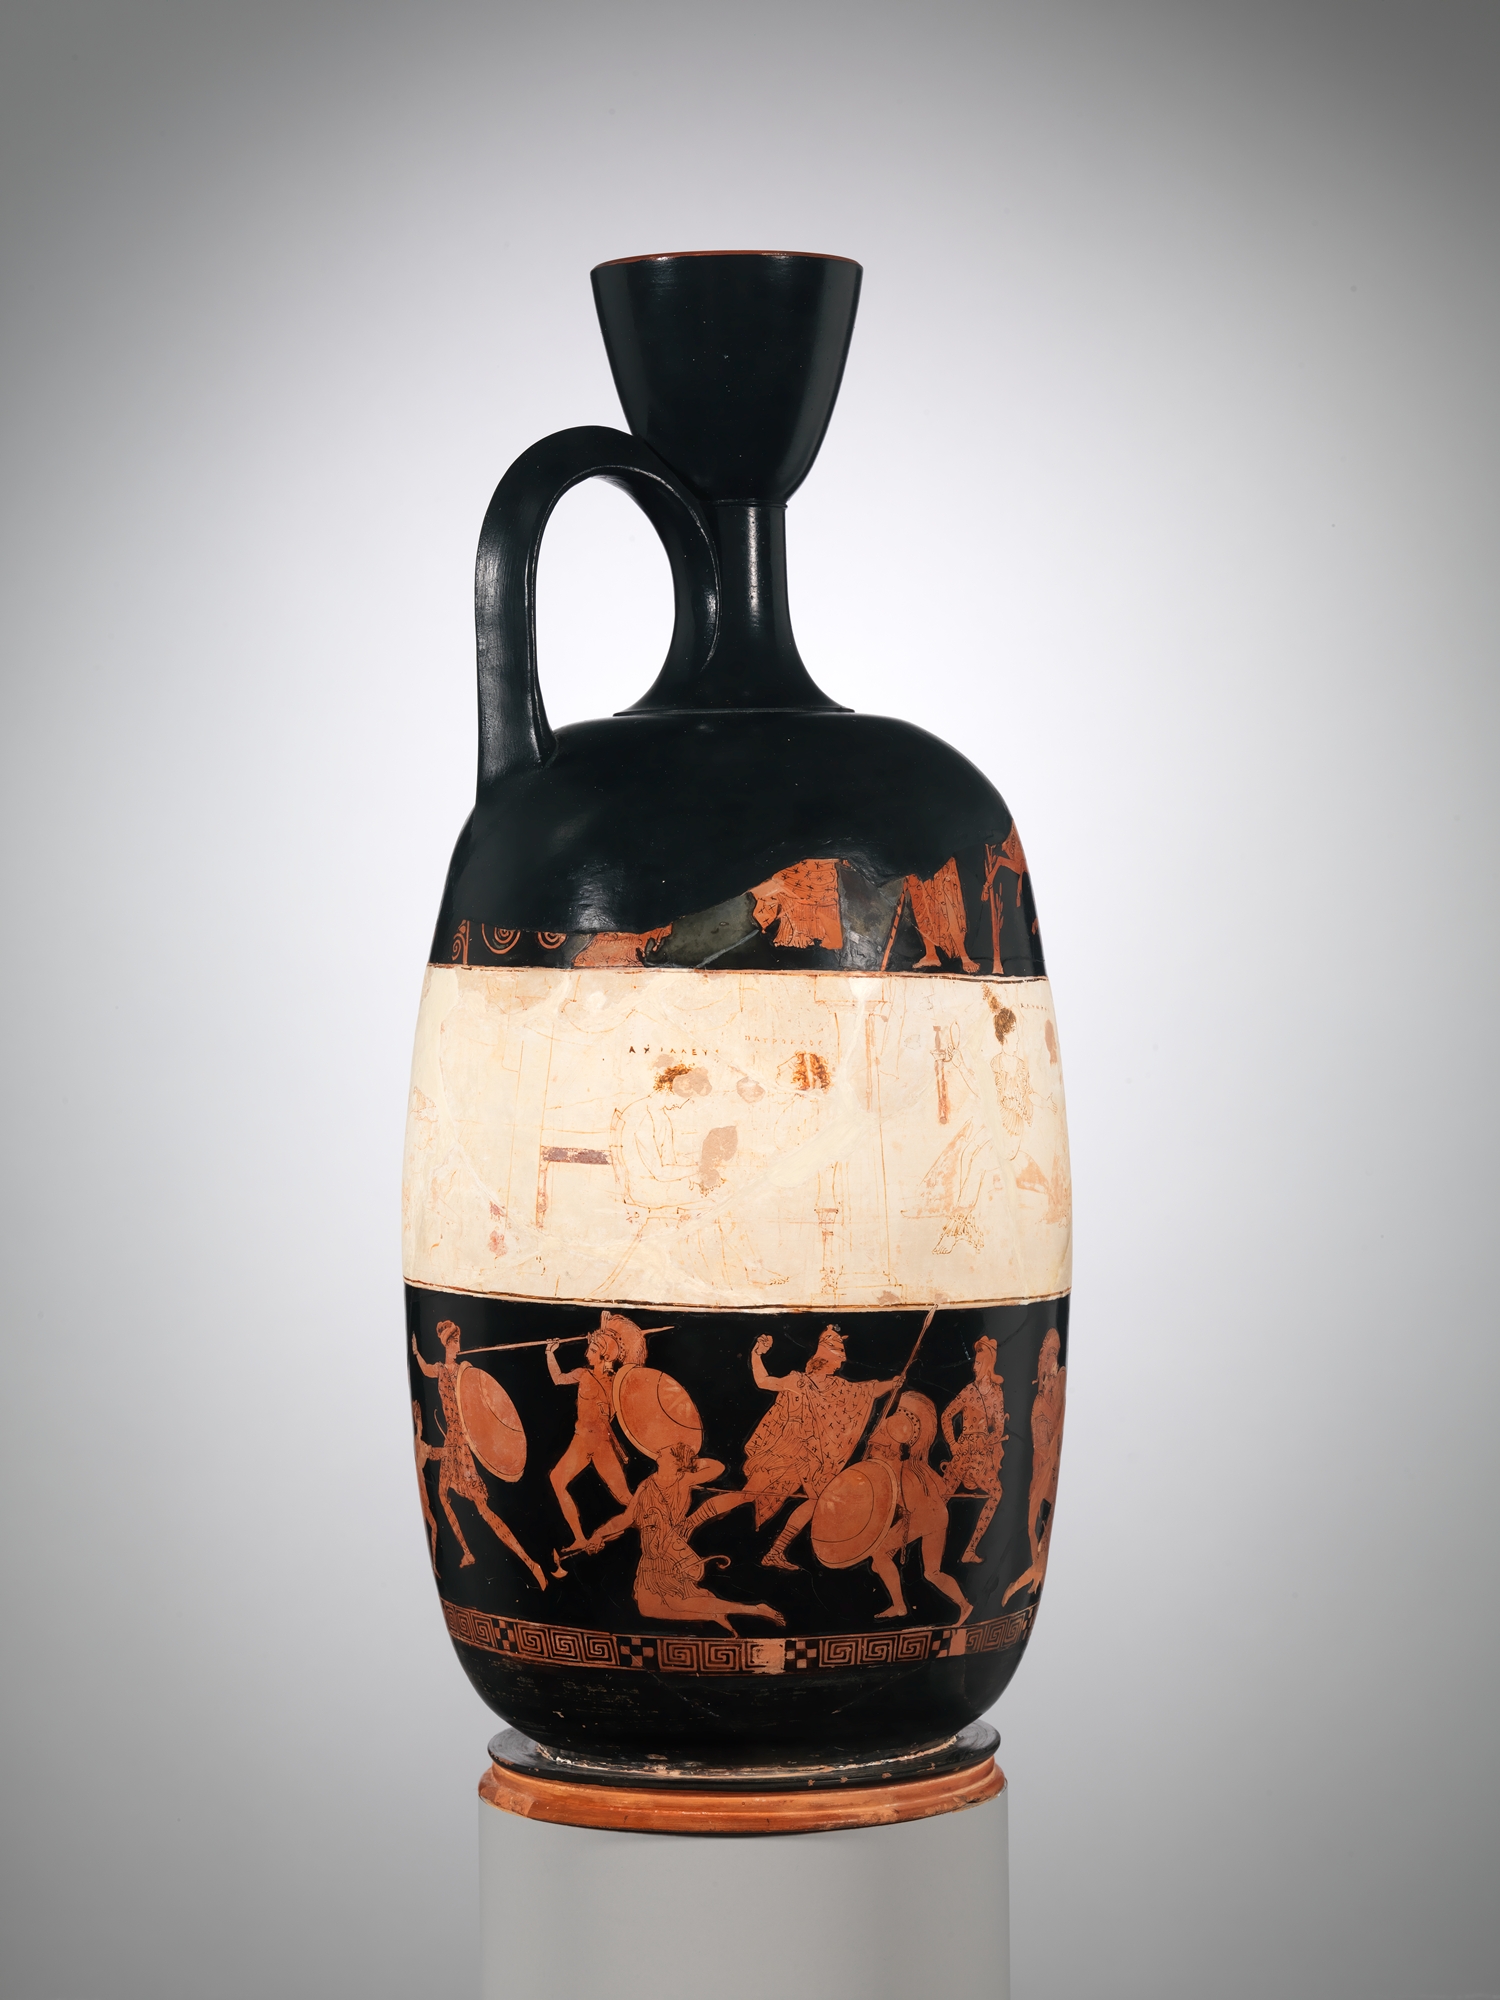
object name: squat lekythos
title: Terracotta lekythos (oil flask)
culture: greek, attic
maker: eretria painter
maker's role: artist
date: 420 BCE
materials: terracotta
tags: battles,men,women,achilles